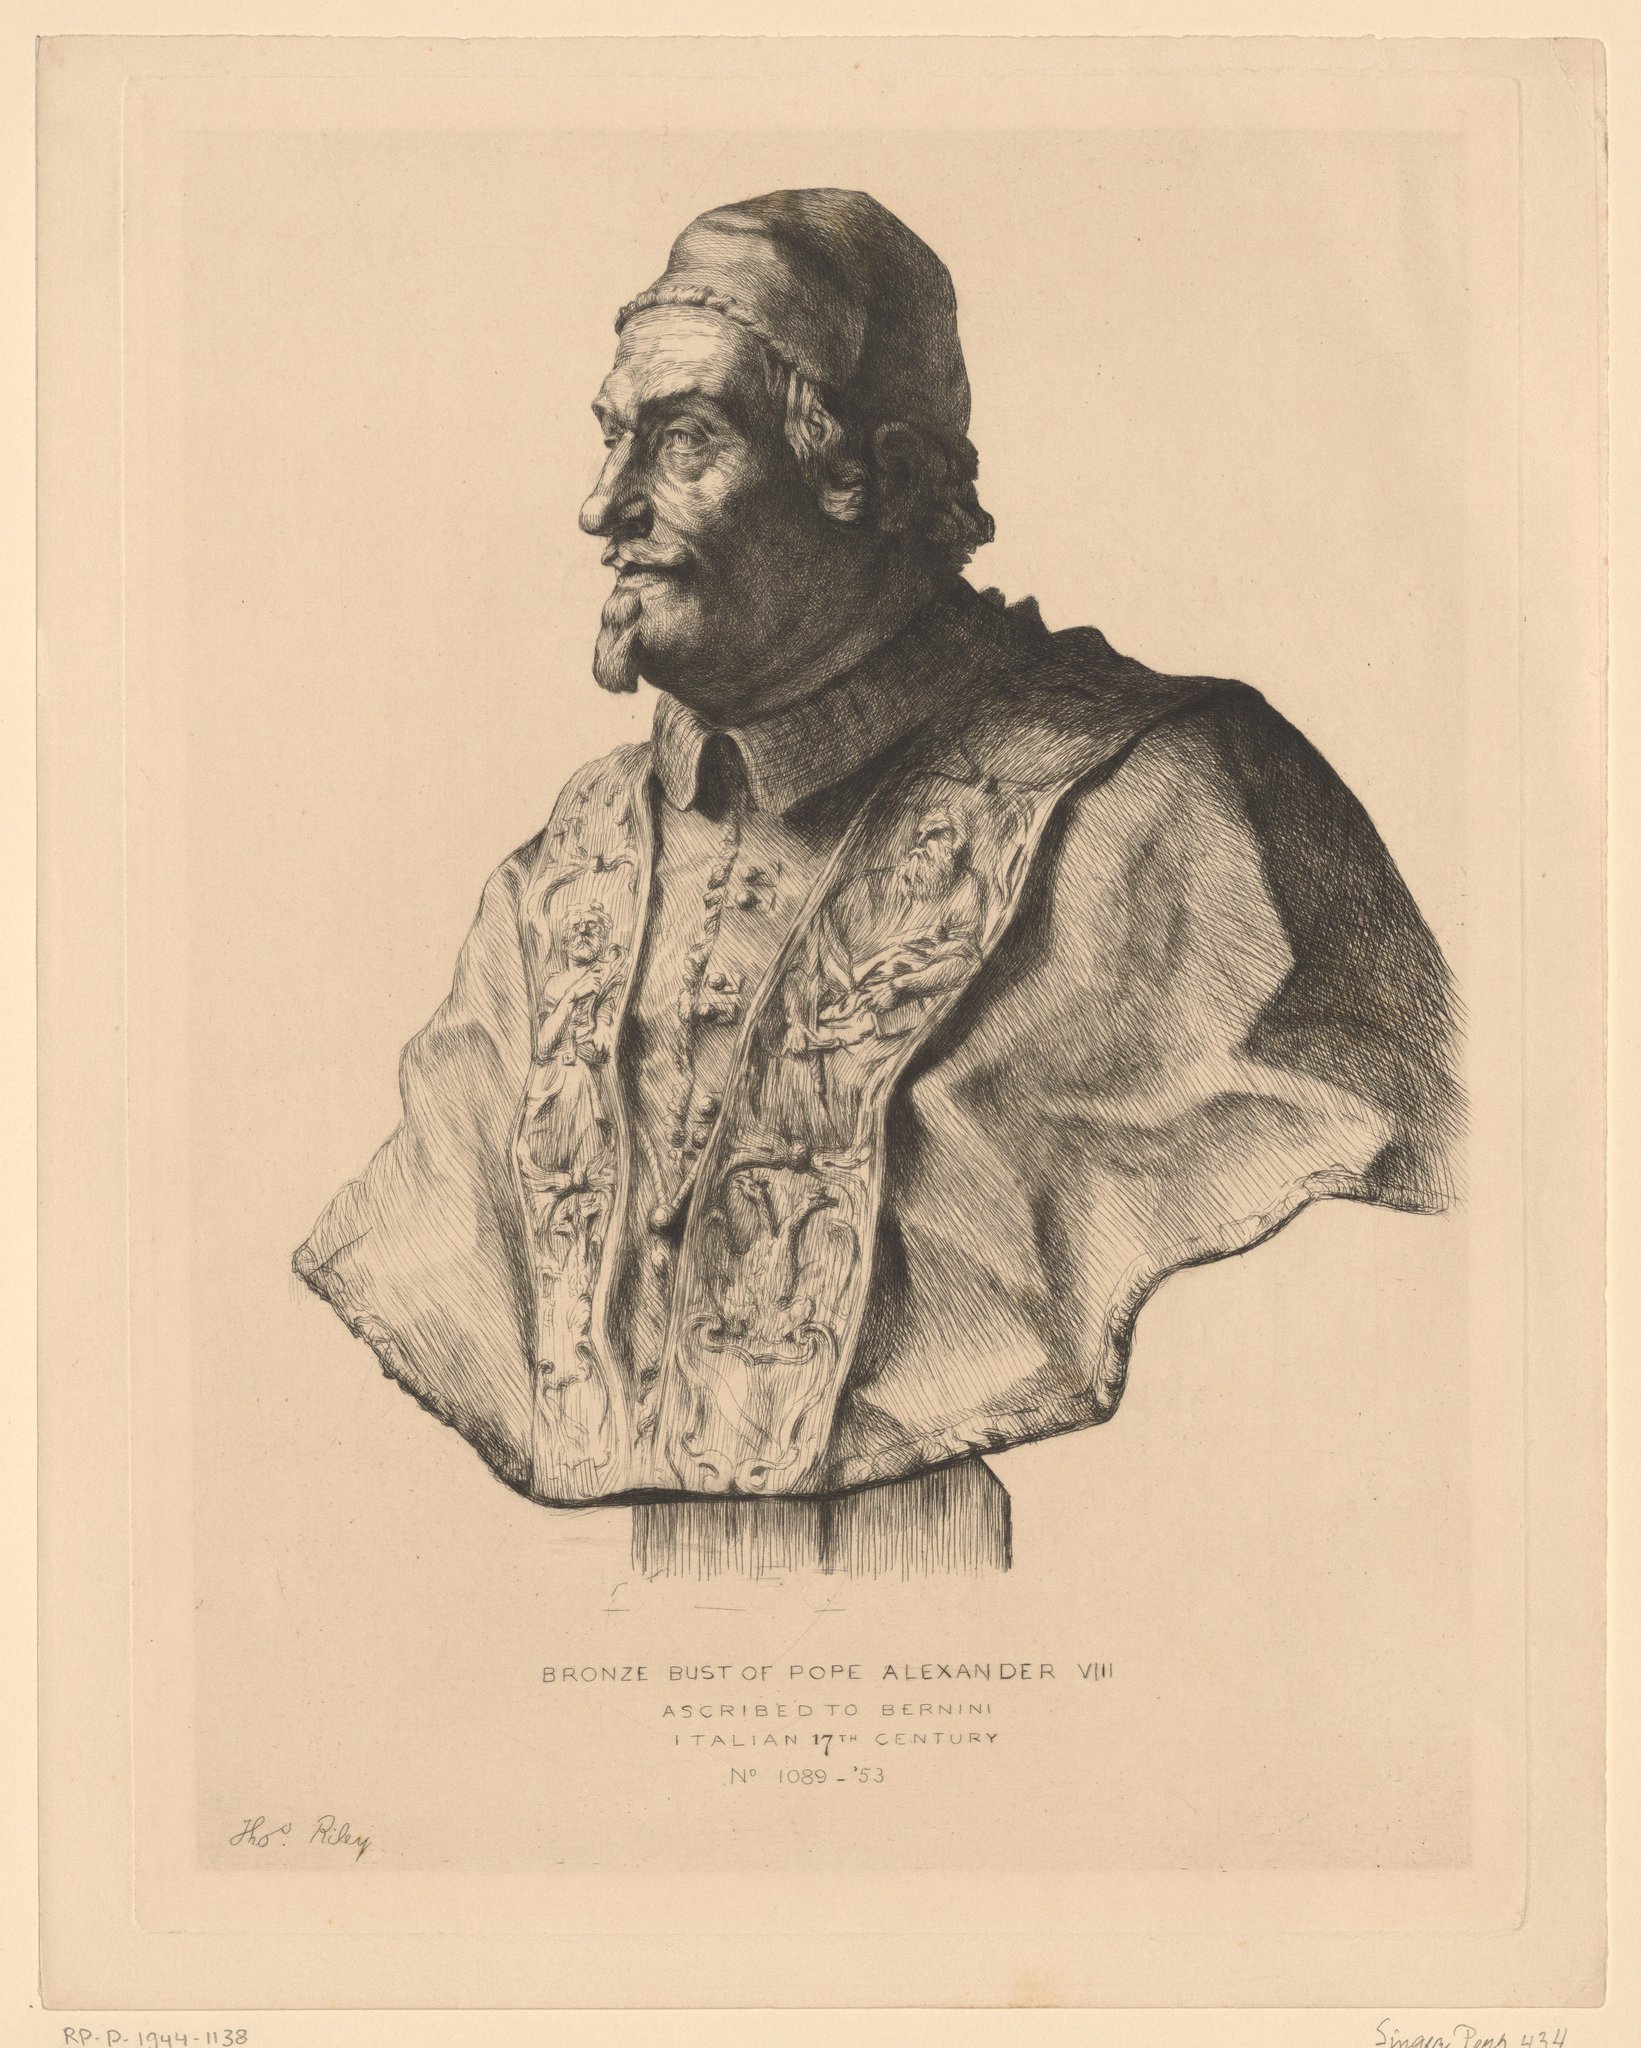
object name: print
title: Buste van paus Alexander VIII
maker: thomas riley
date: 1880-1892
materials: paper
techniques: etching, intaglio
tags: venice, rome, clergyman, alexander viii, historical persons, piece of sculpture, reproduction of a piece of sculpture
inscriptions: collector's mark: Lugt 2228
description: Prent van een bronzen buste uit de collectie van het Victoria and Albert Museum, Londen.